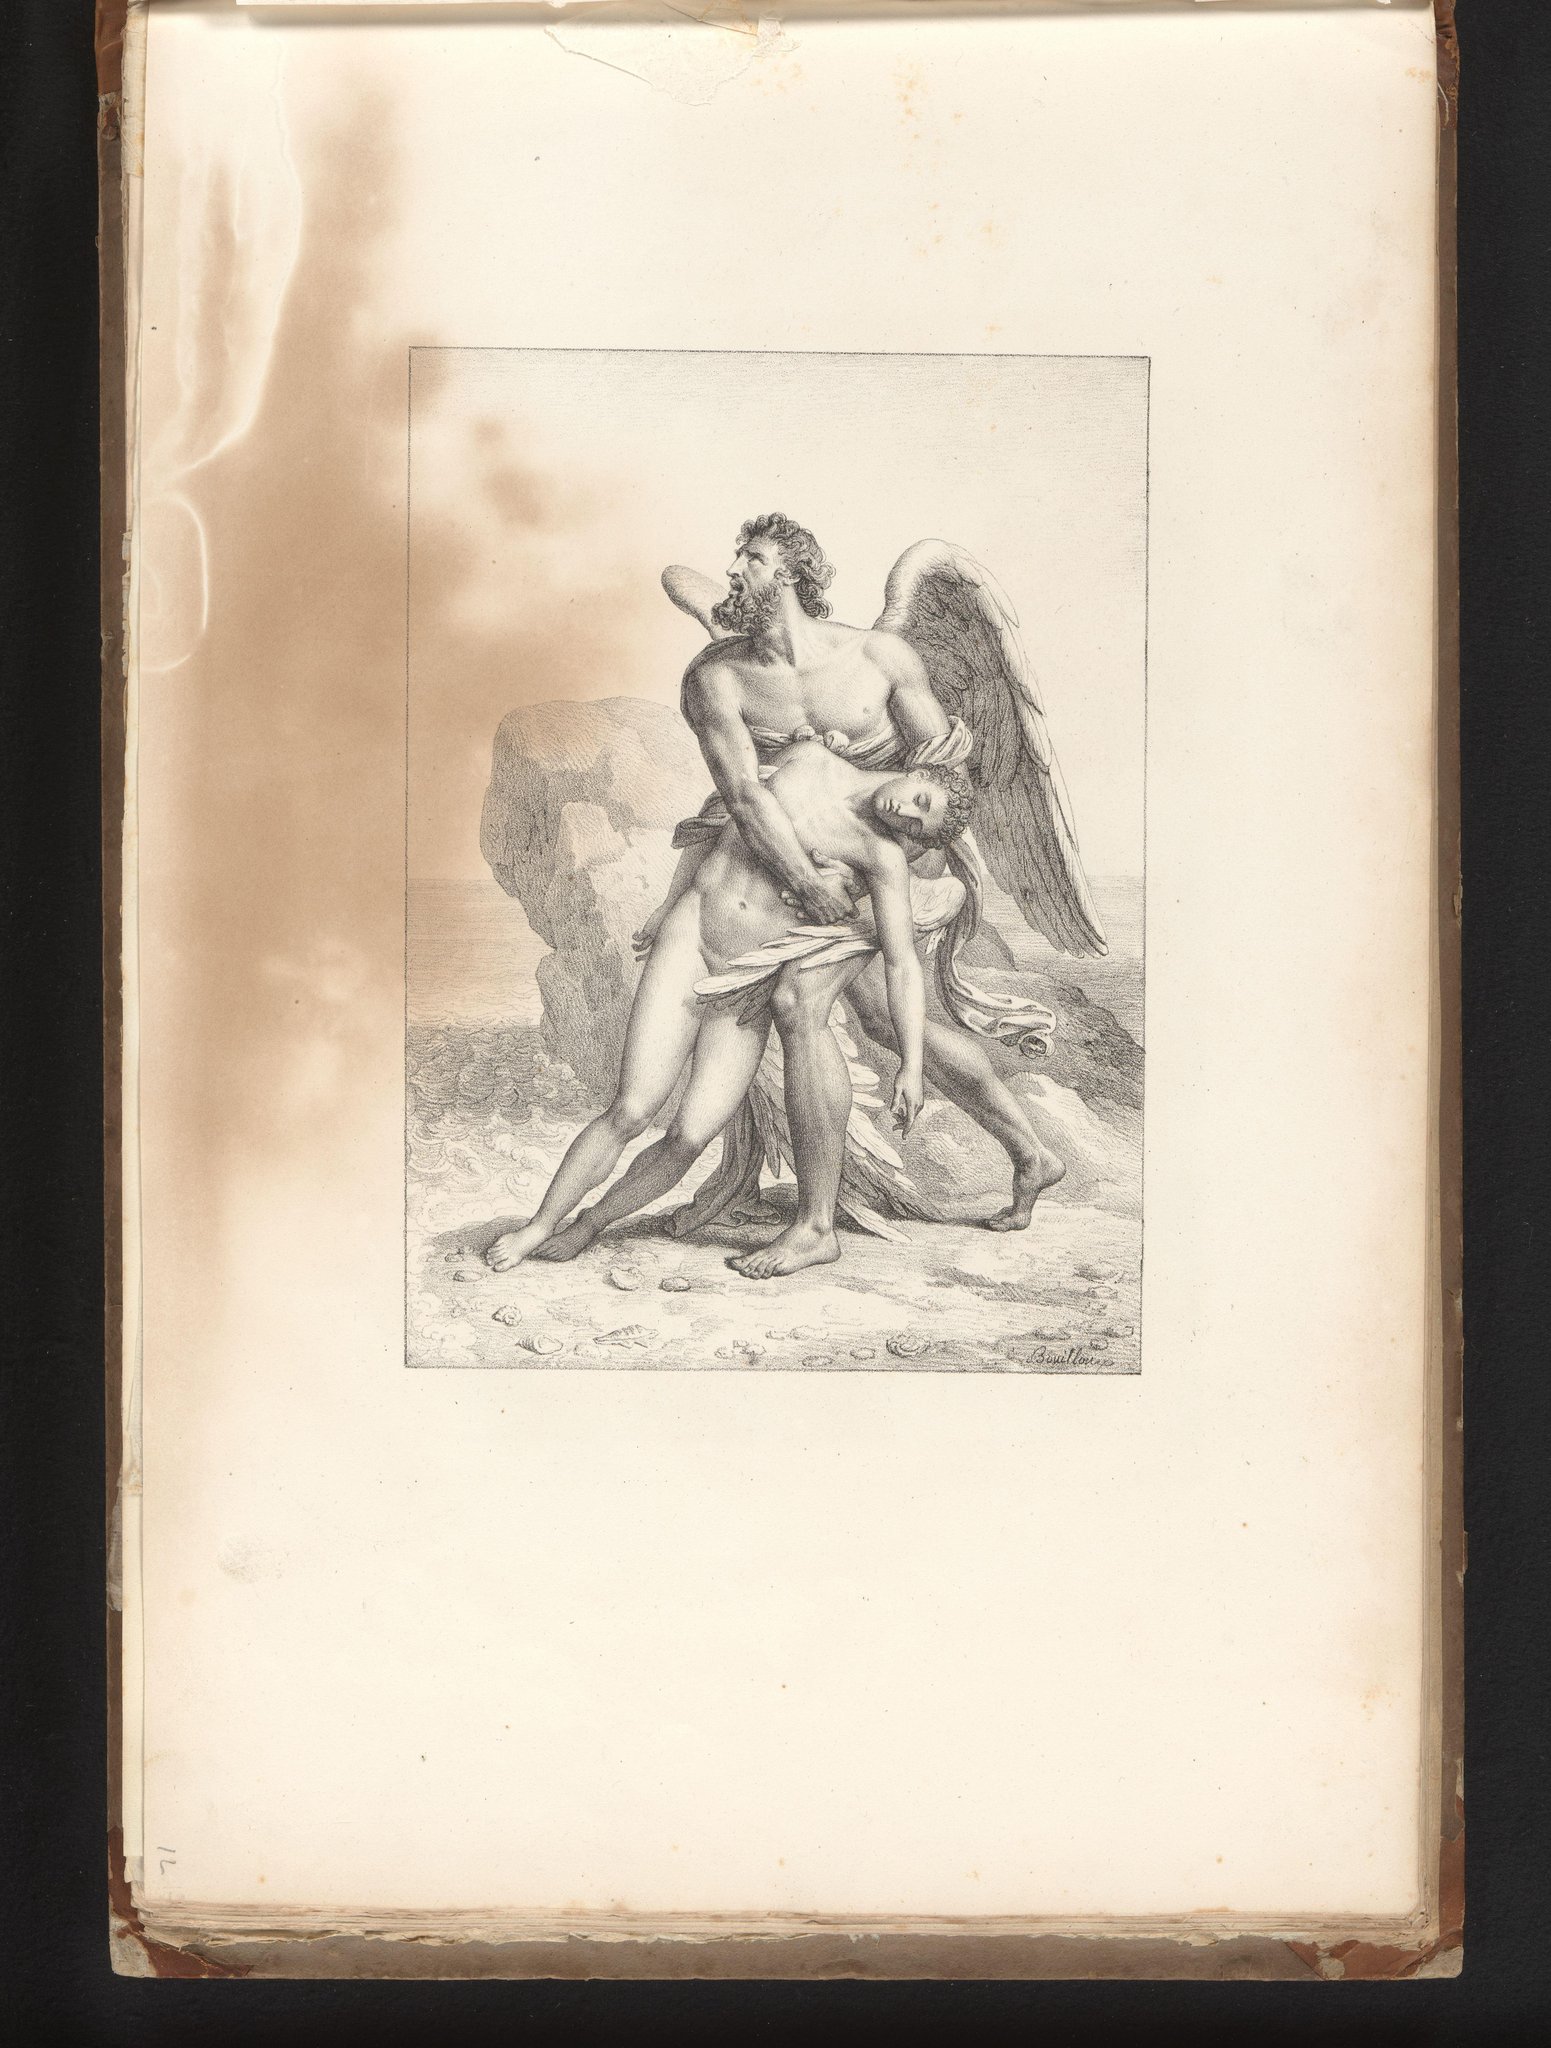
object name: print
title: Gevleugelde jongen opgetild door een gevleugelde man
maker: pierre bouillon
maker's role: painter, print maker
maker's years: 1776-1831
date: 1818-1819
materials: paper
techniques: lithograph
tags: gods ~ classical mythology, classical antiquity (historical epoch)